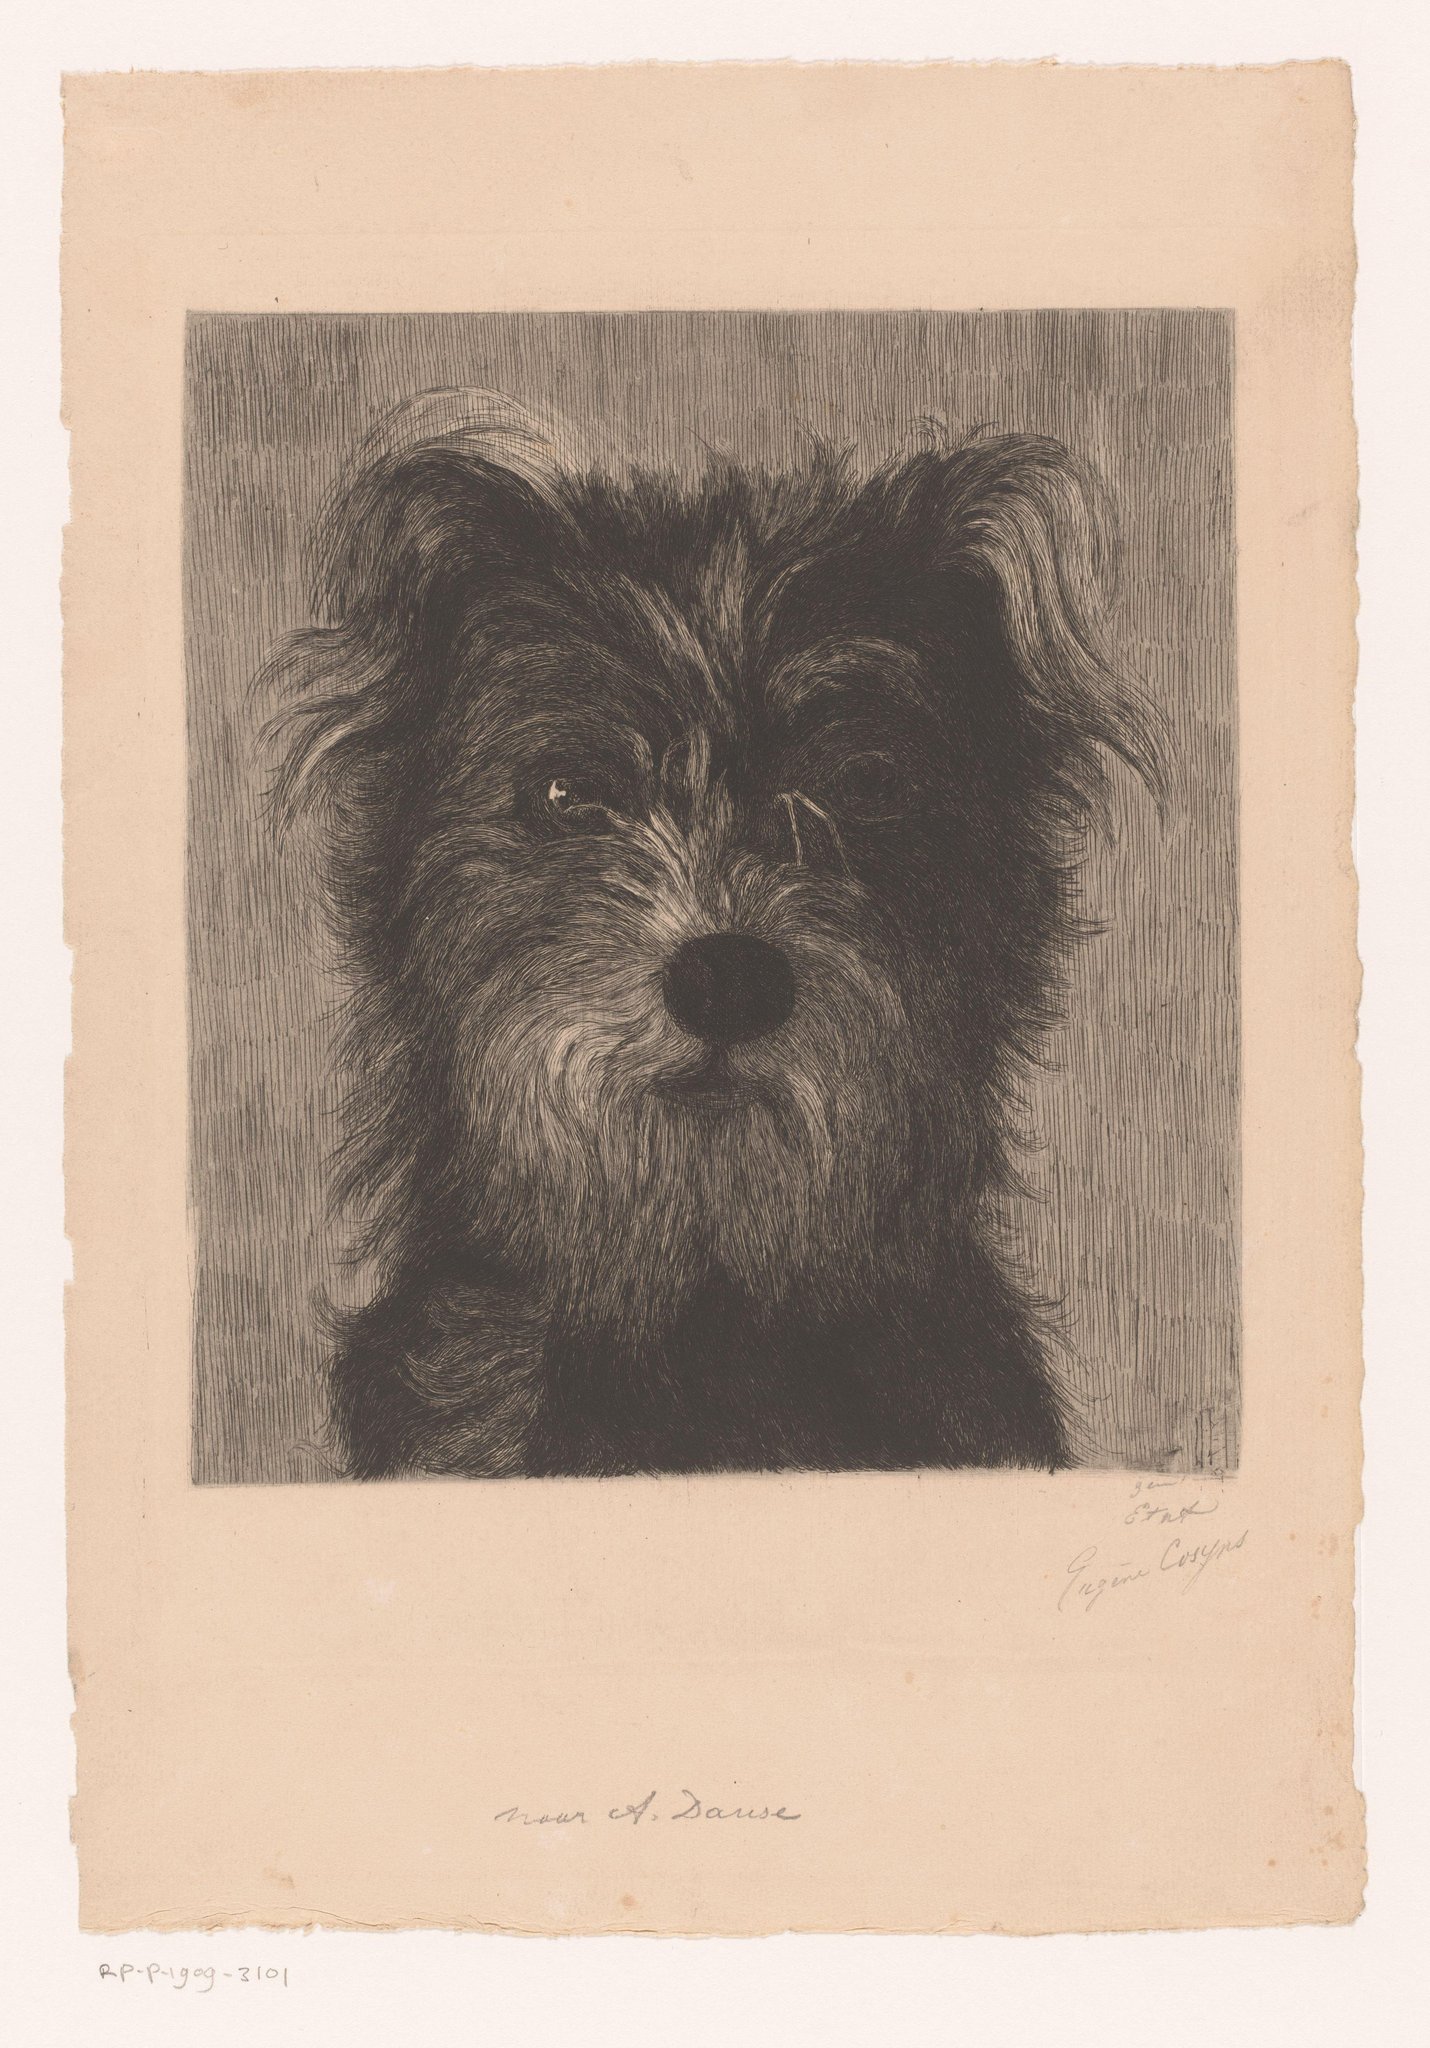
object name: print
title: Kop van een hond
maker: eugène cosyns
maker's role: print maker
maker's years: 1862-1909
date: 1872-1909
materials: paper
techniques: etching, intaglio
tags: dog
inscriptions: inscription: ‘3em etat’, collector's mark: Lugt 2228